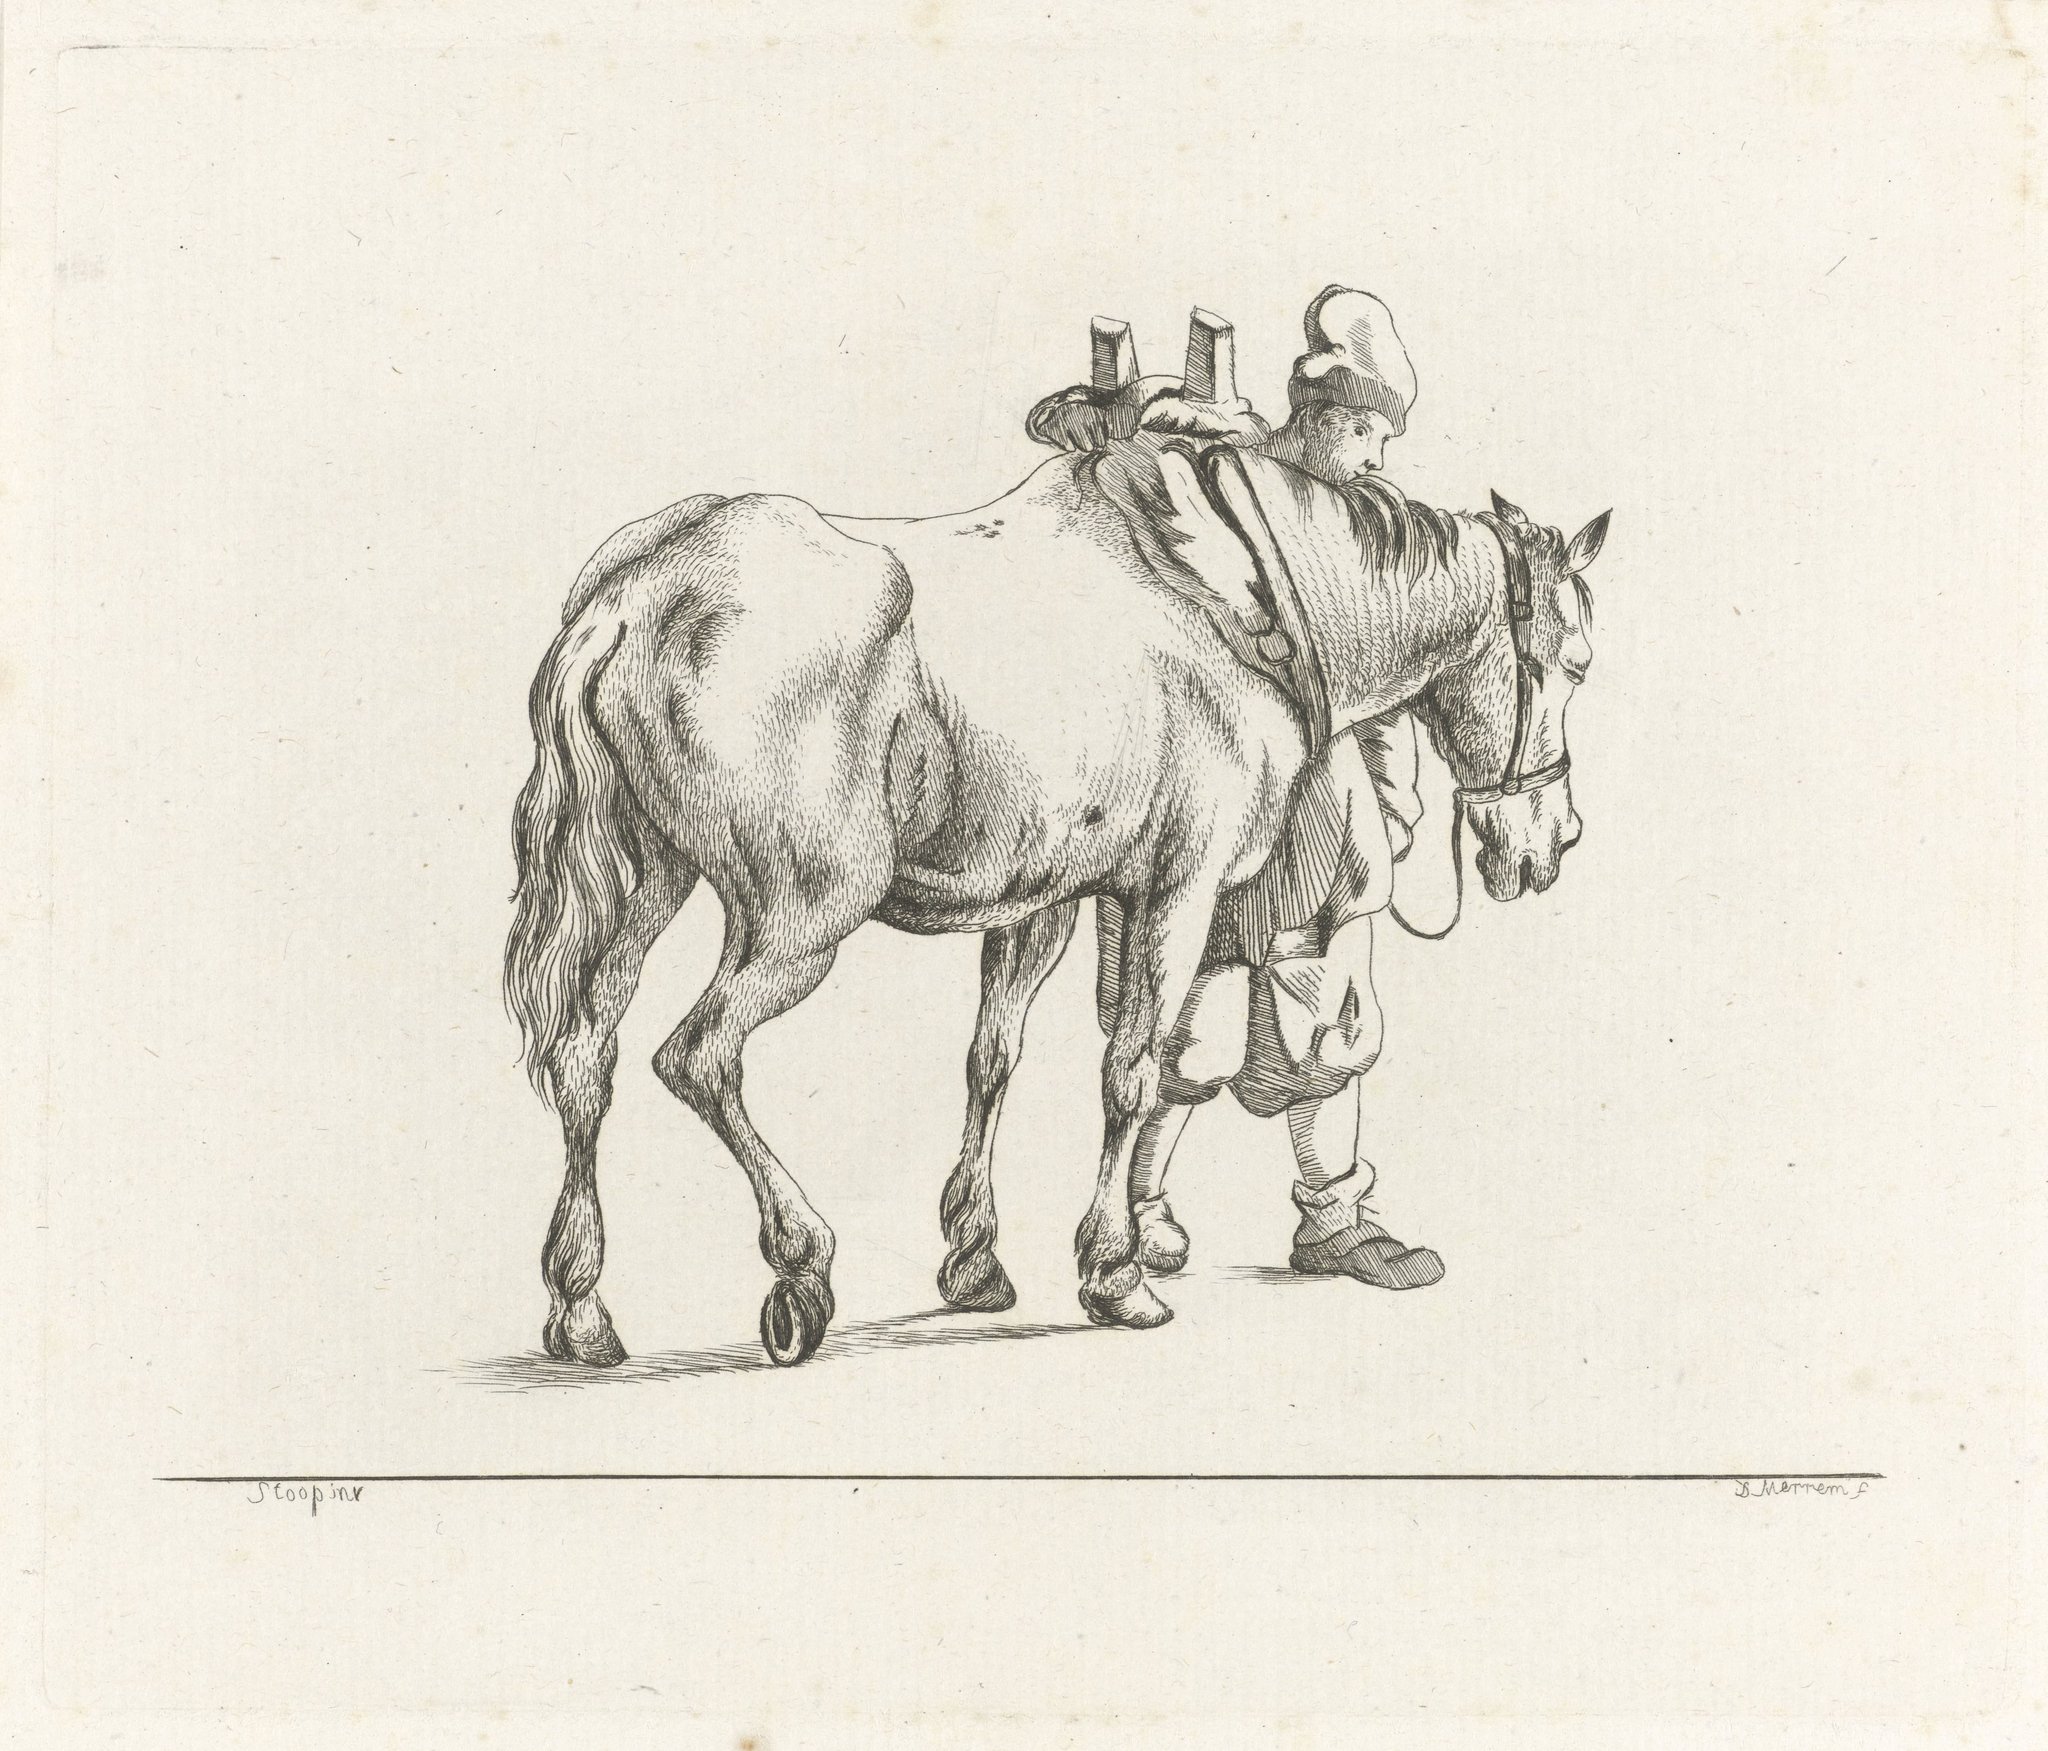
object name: print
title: Man lopend naast een paard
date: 1700-1800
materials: paper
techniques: etching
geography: netherlands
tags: horse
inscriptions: collector's mark: Lugt 2228